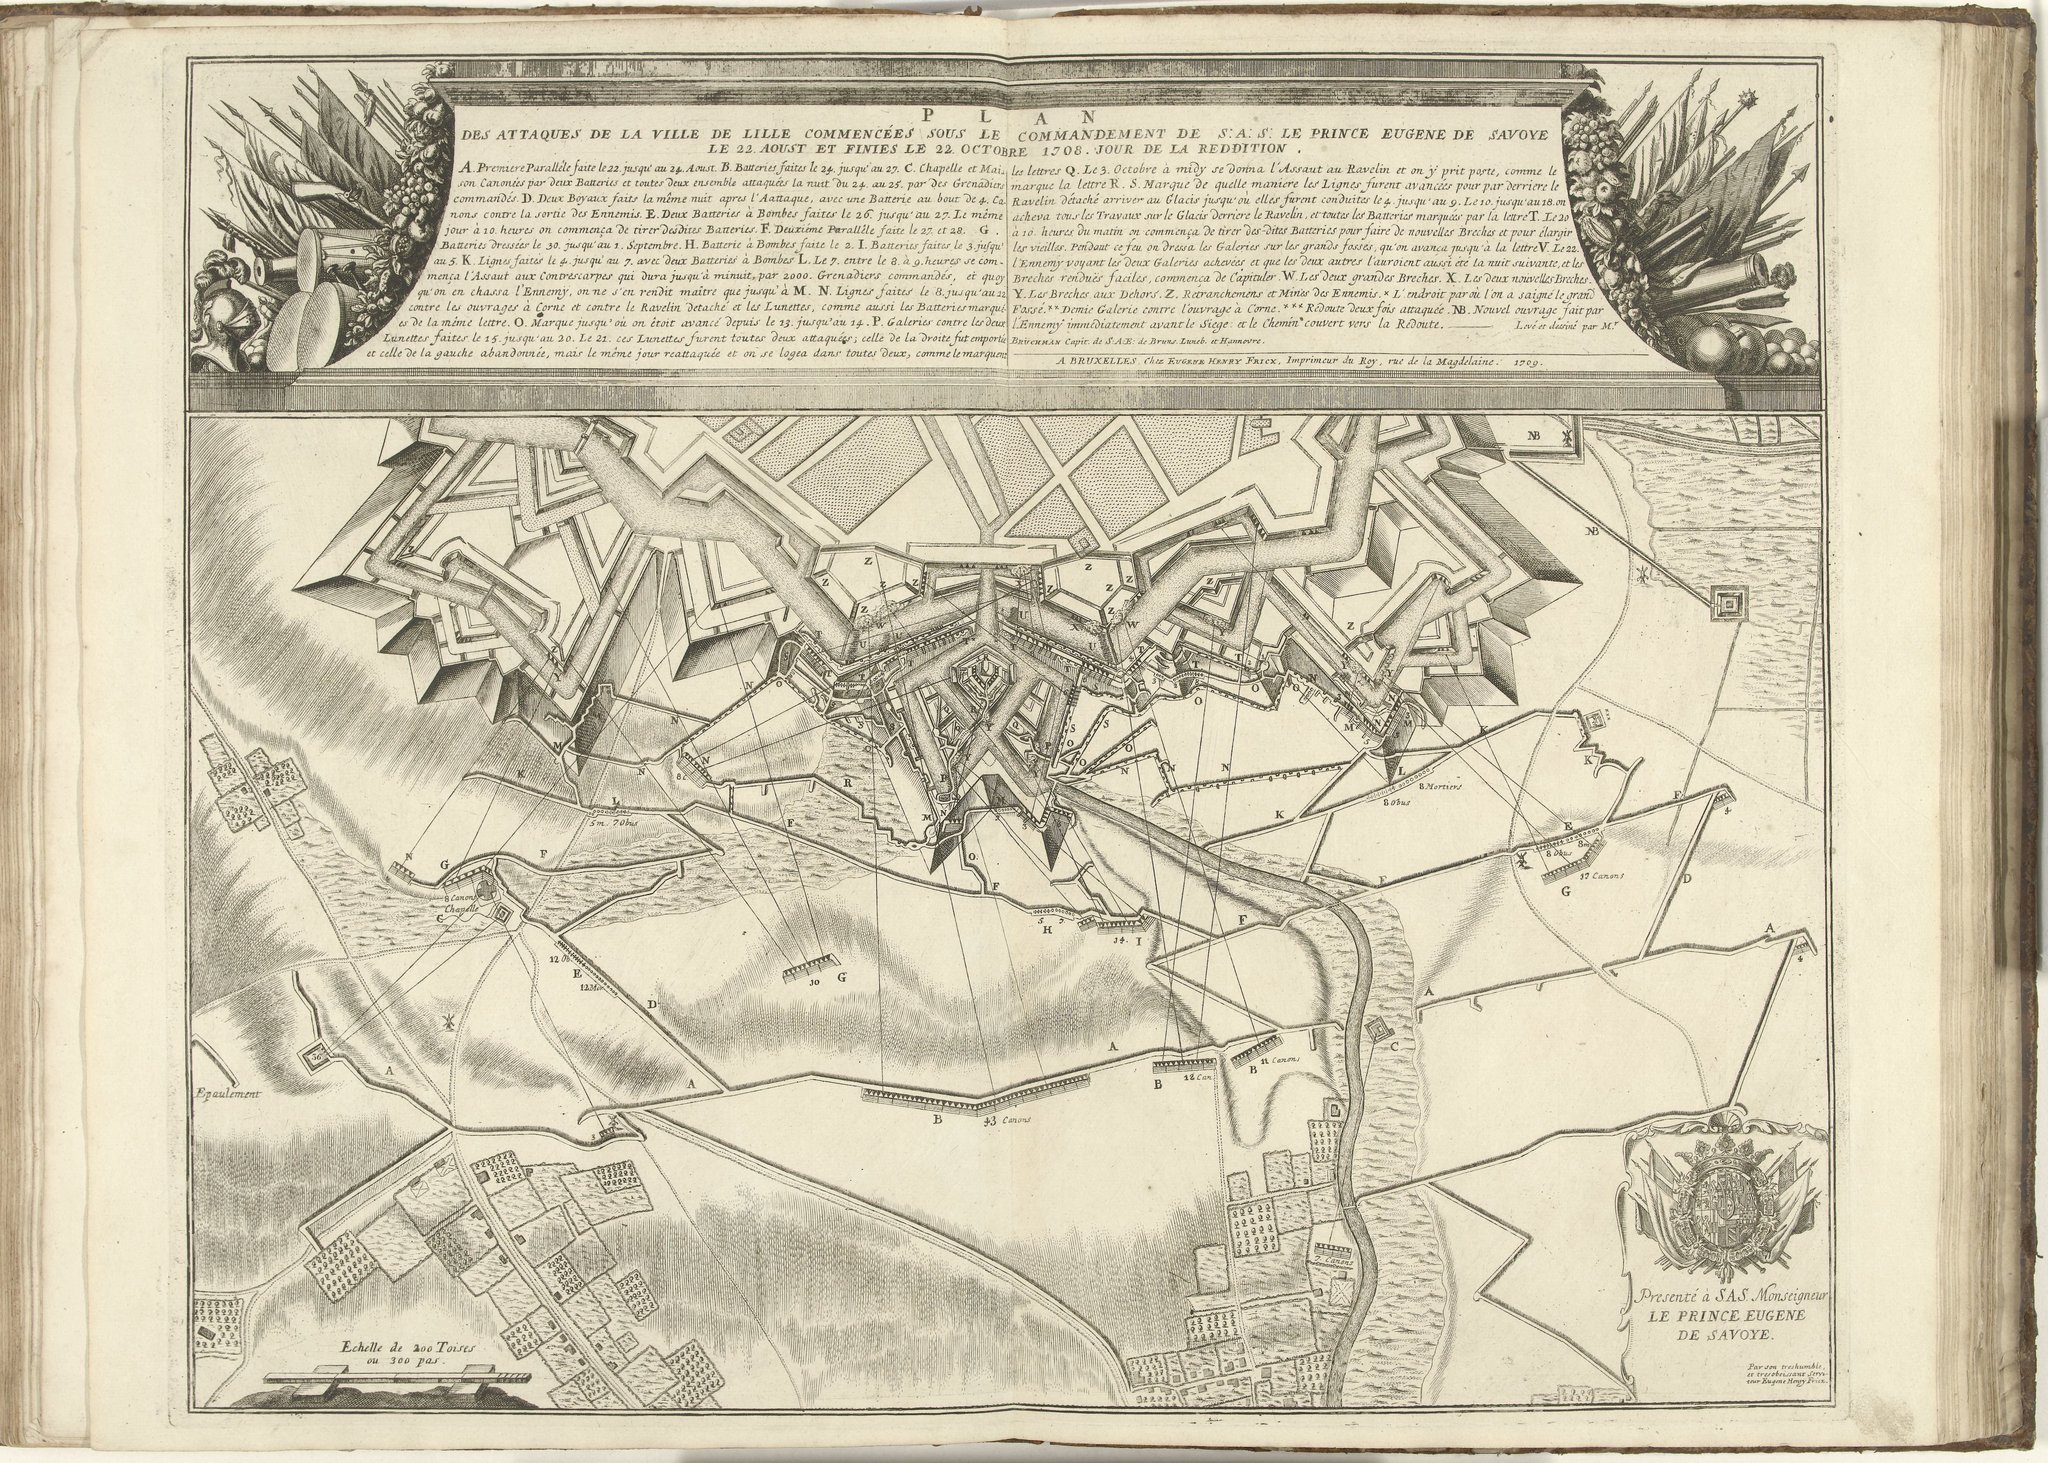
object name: map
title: Kaart van het beleg van Lille, 1708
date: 1709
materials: paper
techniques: engraving, etching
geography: brussels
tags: paris, vienna, eugenius van savoye, fortress, siege, position war, lille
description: Plattegrond van de versterkingen van Lille (Rijssel), belegerd vanaf 22 augustus door de Geallieerden onder prins Eugenius van Savoye. Bovenaan een voetstuk met de titel en legenda A-Z in het Frans. Onderdeel van een gebundelde verzameling van plannen van veldslagen en steden vermaard in de Spaanse Successieoorlog.